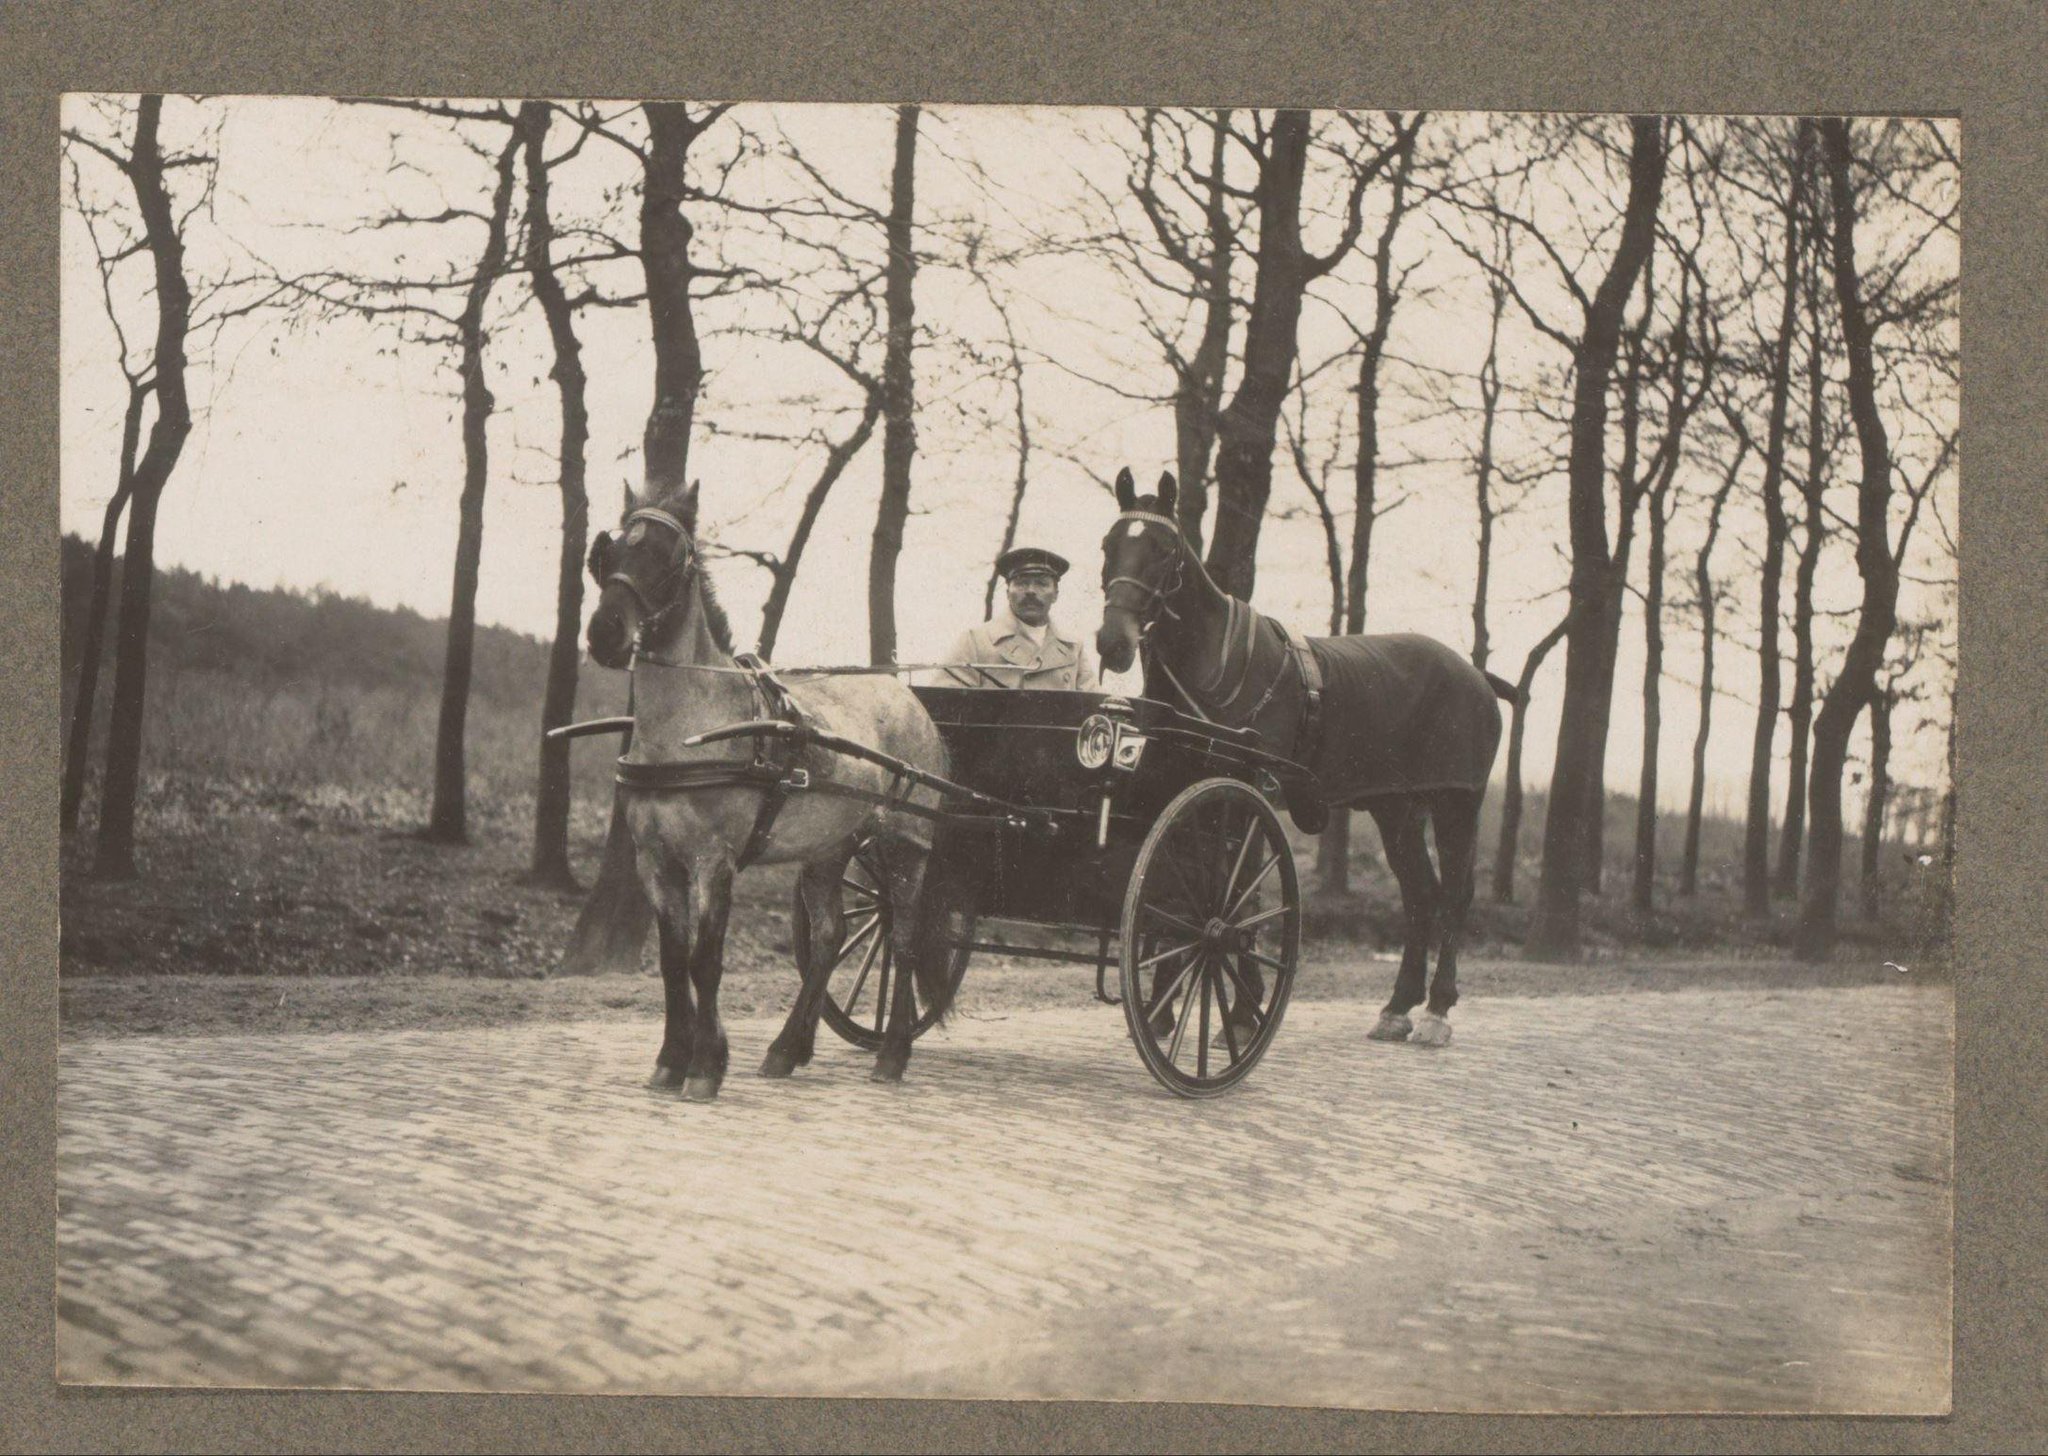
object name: photograph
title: Ruitertafereel op Koninklijke Houtvesterij Het Loo: man in rijtuig met ingespannen paard en paard erachter op een klinkerweg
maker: Anonymous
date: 1900-1925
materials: photographic support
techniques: gelatin silver print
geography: het loo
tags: hunting, chase, hunting-ground, two-wheeled, animal-drawn vehicle, horse, public road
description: Onderdeel van Fotoalbum van de heer Brams, opperhoutvester van koningin Wilhelmina op Koninklijke Houtvesterij Het Loo.